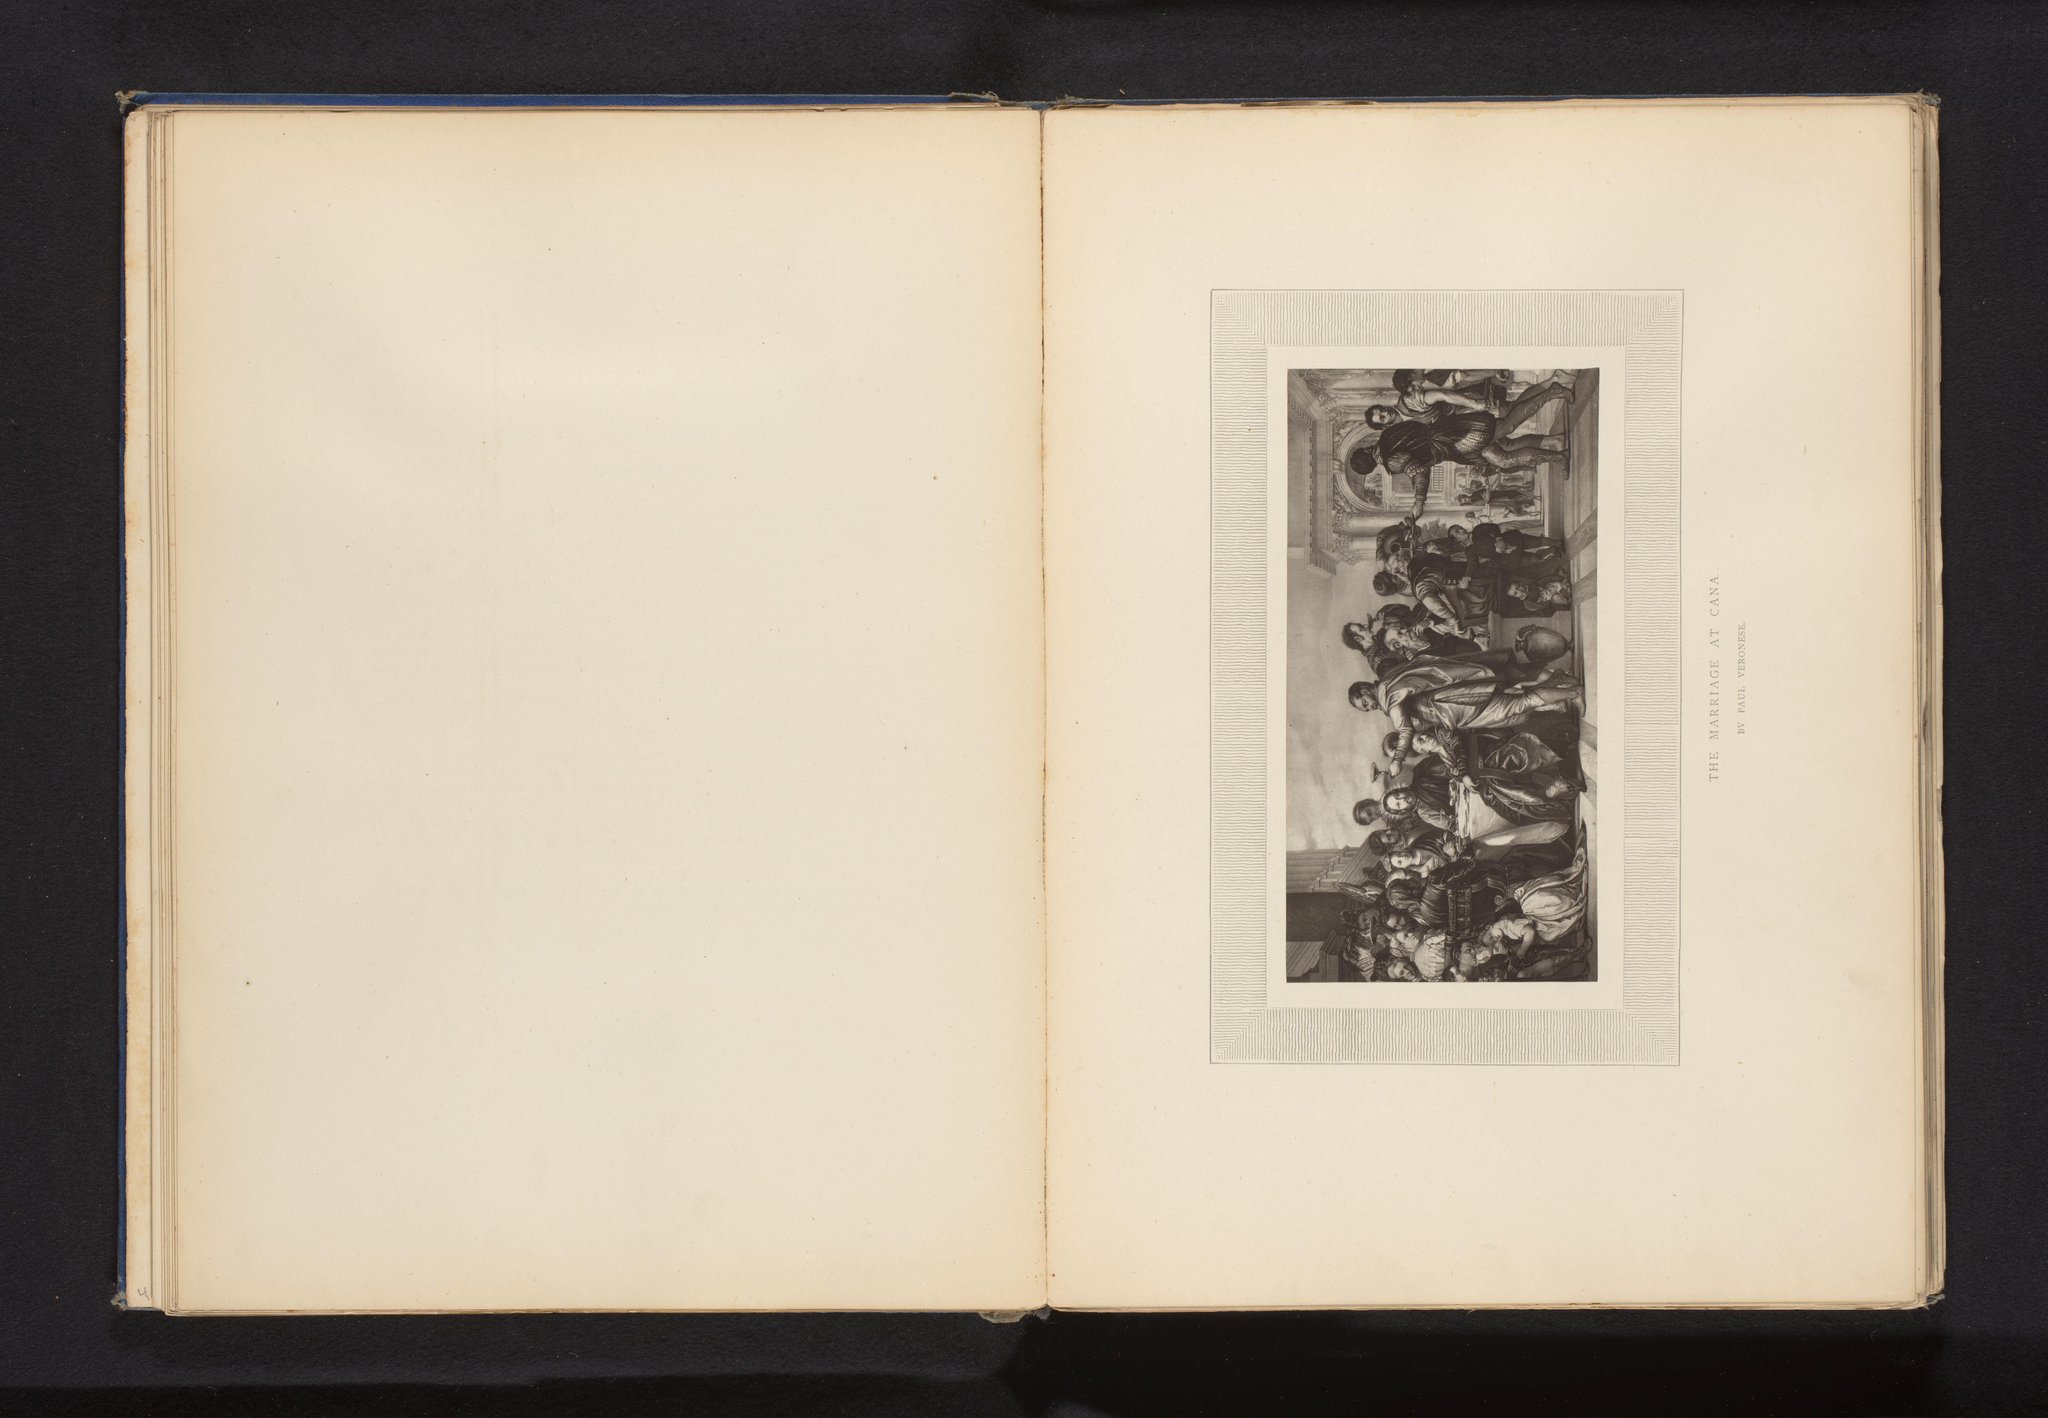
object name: reproduction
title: Reproductie van een prent van de bruiloft te Kana naar Paolo Veronese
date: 1870-1875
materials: paper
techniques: woodburytype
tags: the marriage-feast at cana (john 2:1-11)